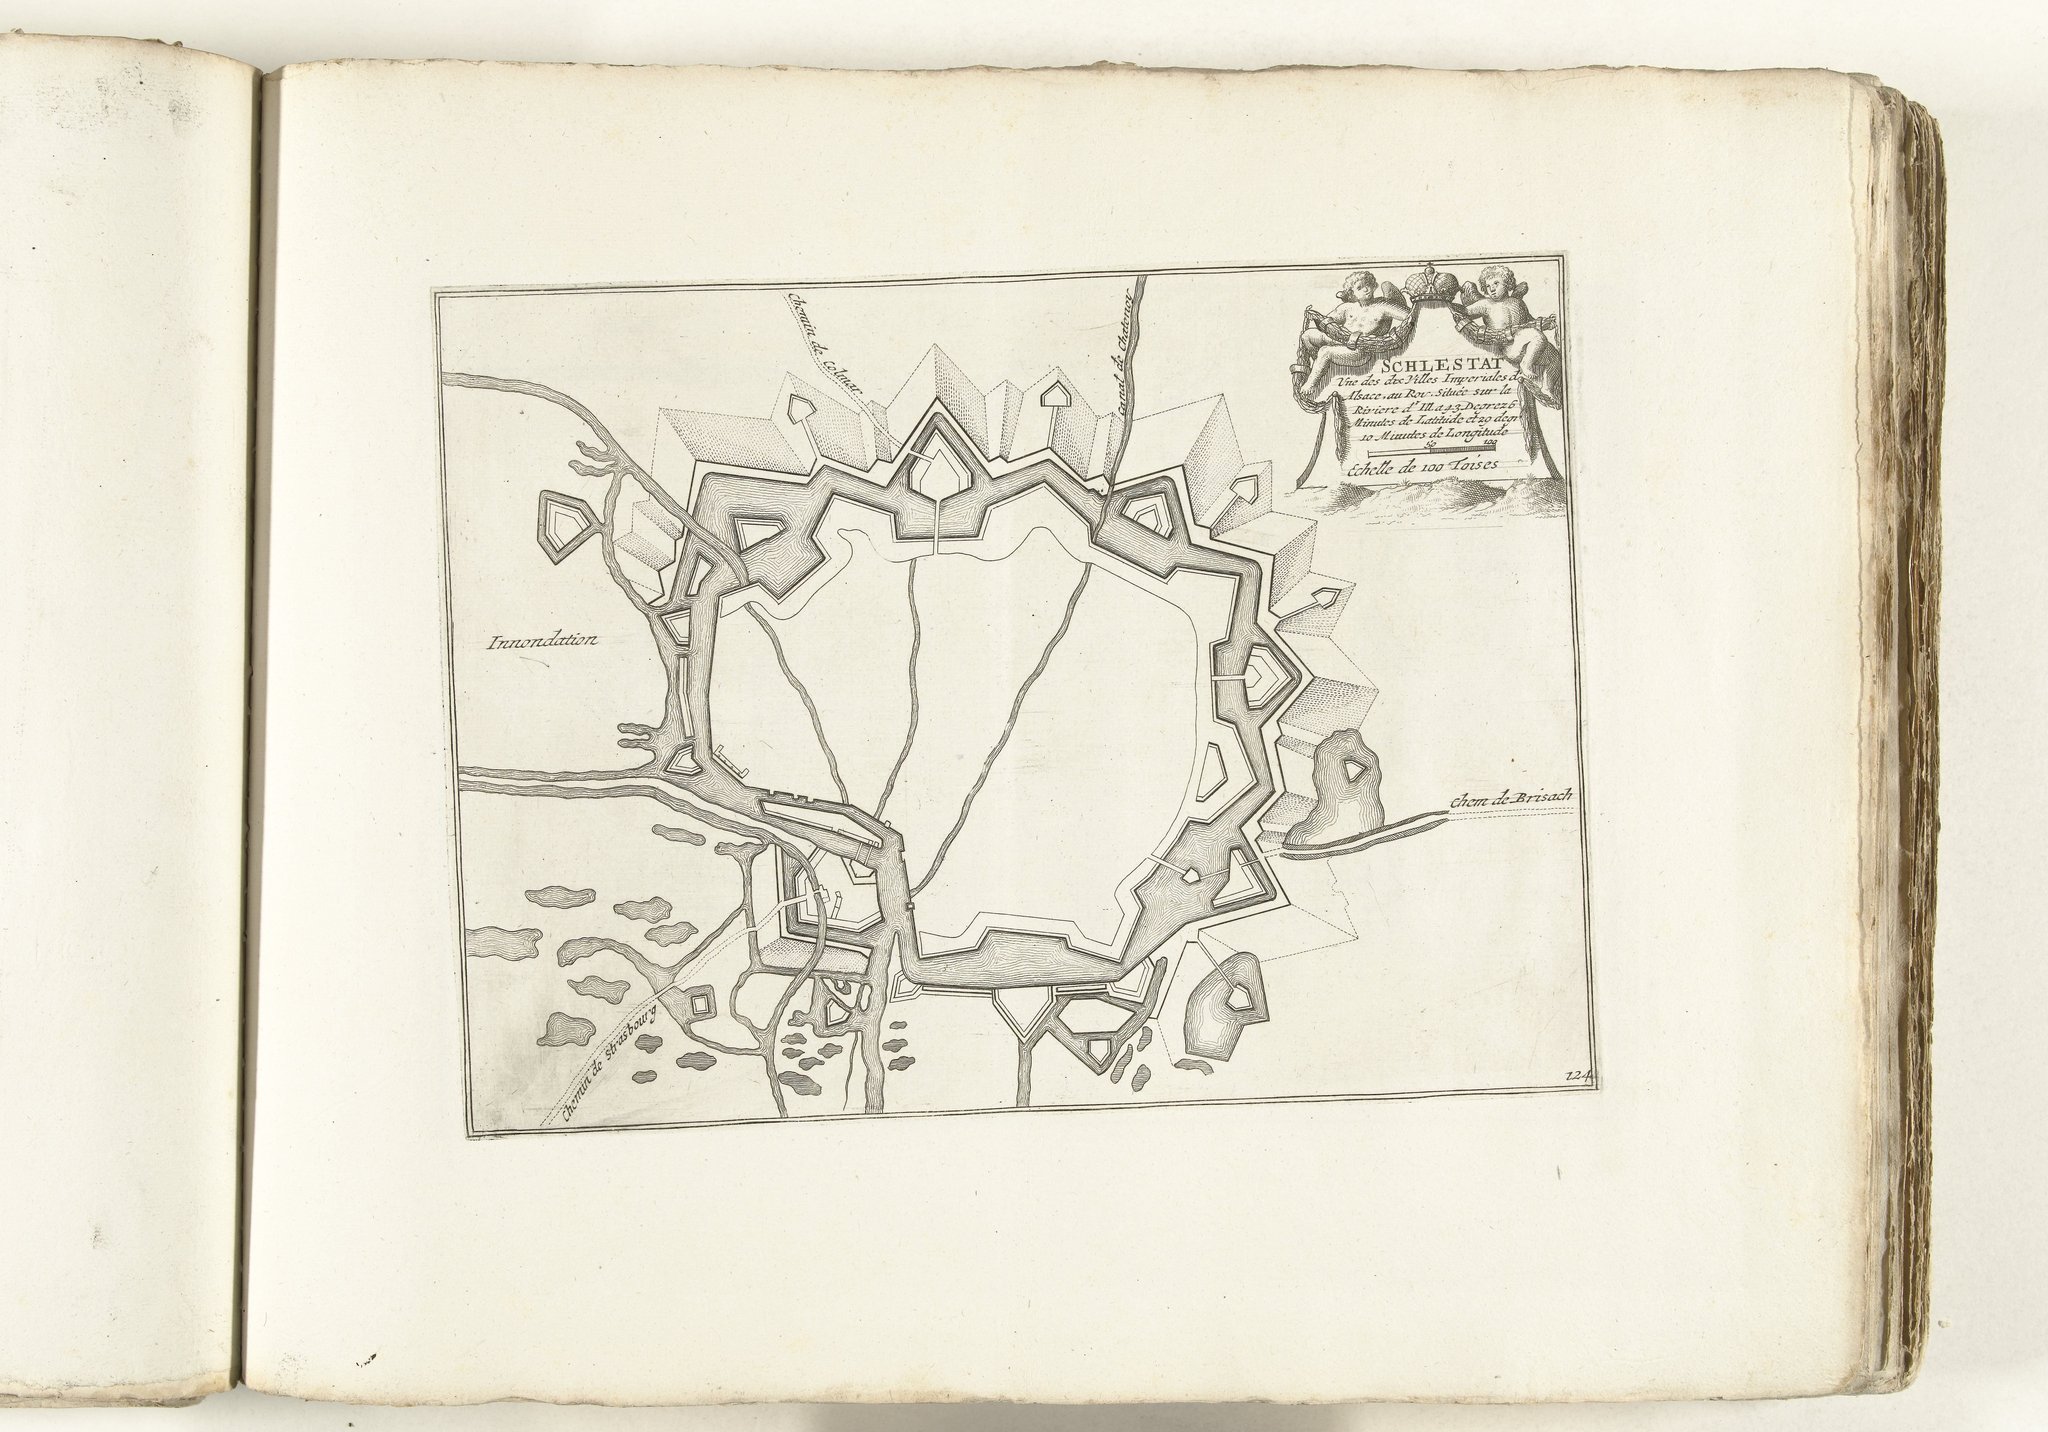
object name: map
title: Les Forces de l'Europe, Asie, Afrique et Amerique, ou description des principales villes avec leurs fortifications. Dessignées par les meilleurs ingenieurs, particulierement celles qui sont sous la domination de la France (...) et ornées de plusieurs superbes edifices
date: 1702-1703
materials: paper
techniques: etching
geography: northern netherlands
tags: fortress, maps of cities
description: Plattegrond van de versterkingen om de stad Schlettstadt. Plaat nr. 124 in het prentwerk bestaande in totaal uit 276 genummerde platen van vermaarde sterke steden en vestingen in het kader van de Spaanse Successieoorlog. Voor het merendeel zijn deze platen gekopieerd naar de anonieme Franse platen: in Les forces de l'Europe en in: Le theatre de la guerre, dans les Pays-Bas, beide oorspronkelijk uitgegeven door Nicolas de Fer te Parijs (1693-1697) in het kader van de Negenjarige Oorlog. Titel en opschriften in de plaat in het Frans.